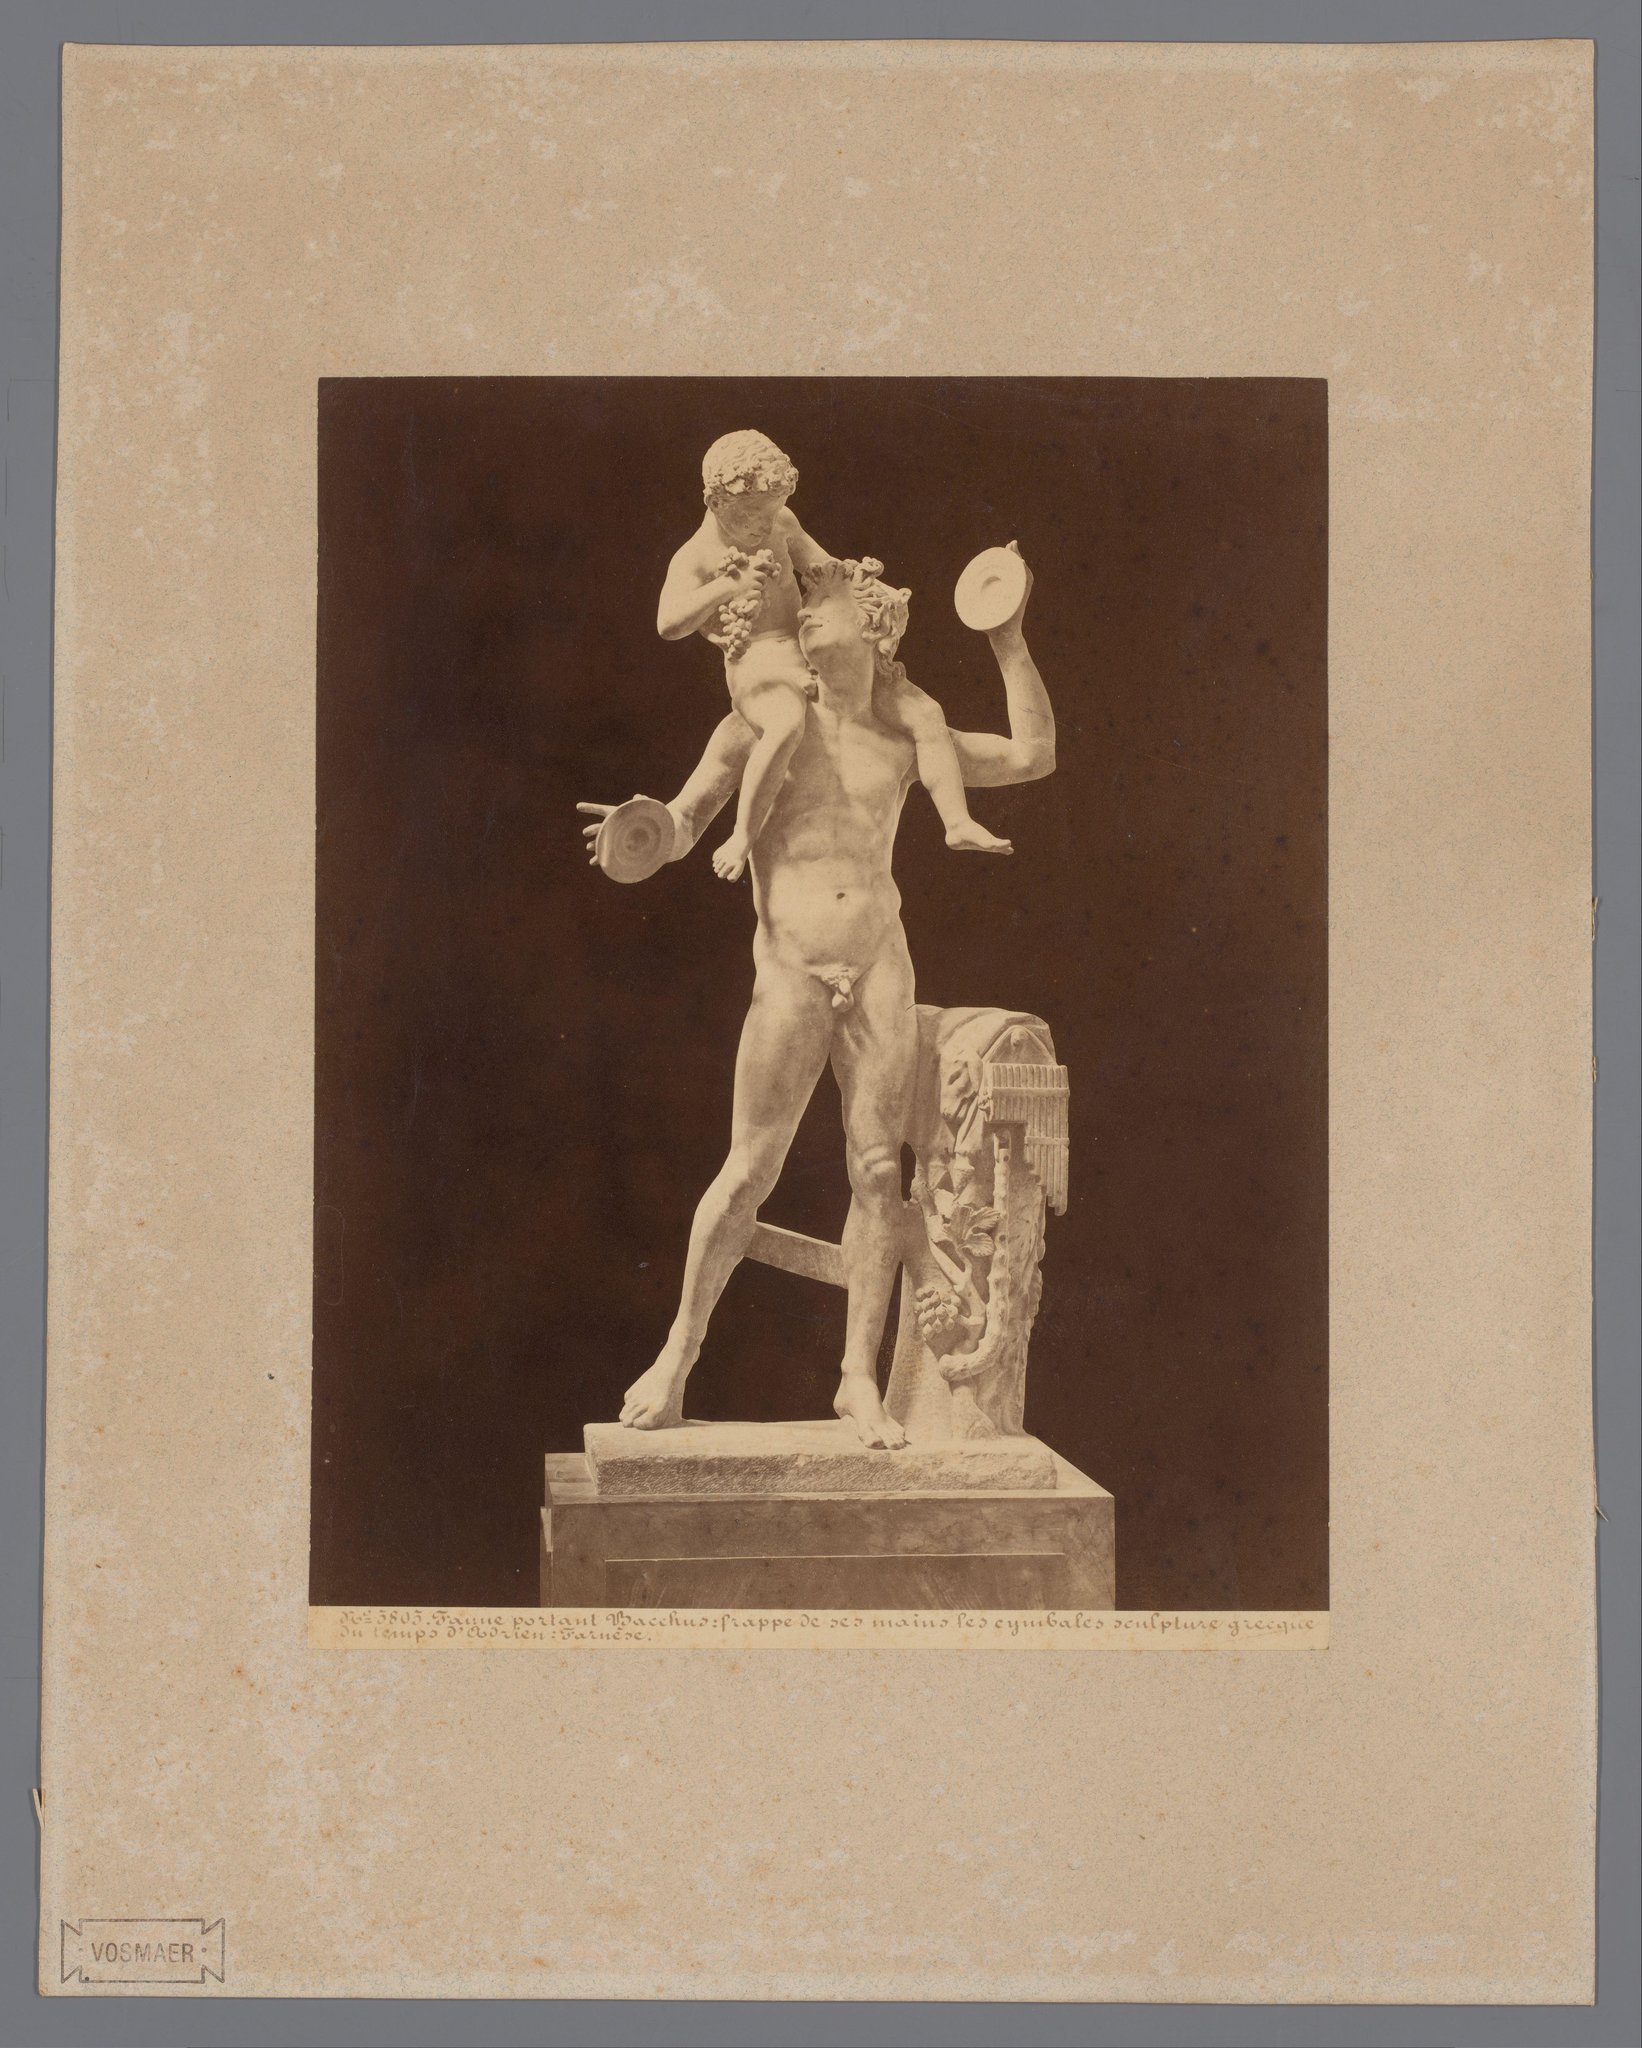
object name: photograph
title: Sculptuur van een faun die Bacchus draagt in de Farnese collectie te Napels, Italië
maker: giorgio sommer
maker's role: fotograaf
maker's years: 1834-1914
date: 1857-1914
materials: cardboard, paper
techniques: albumen print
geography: naples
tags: piece of sculpture, reproduction of a piece of sculpture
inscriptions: number: ‘No 5805.’, collector's mark: ‘VOSMAER’